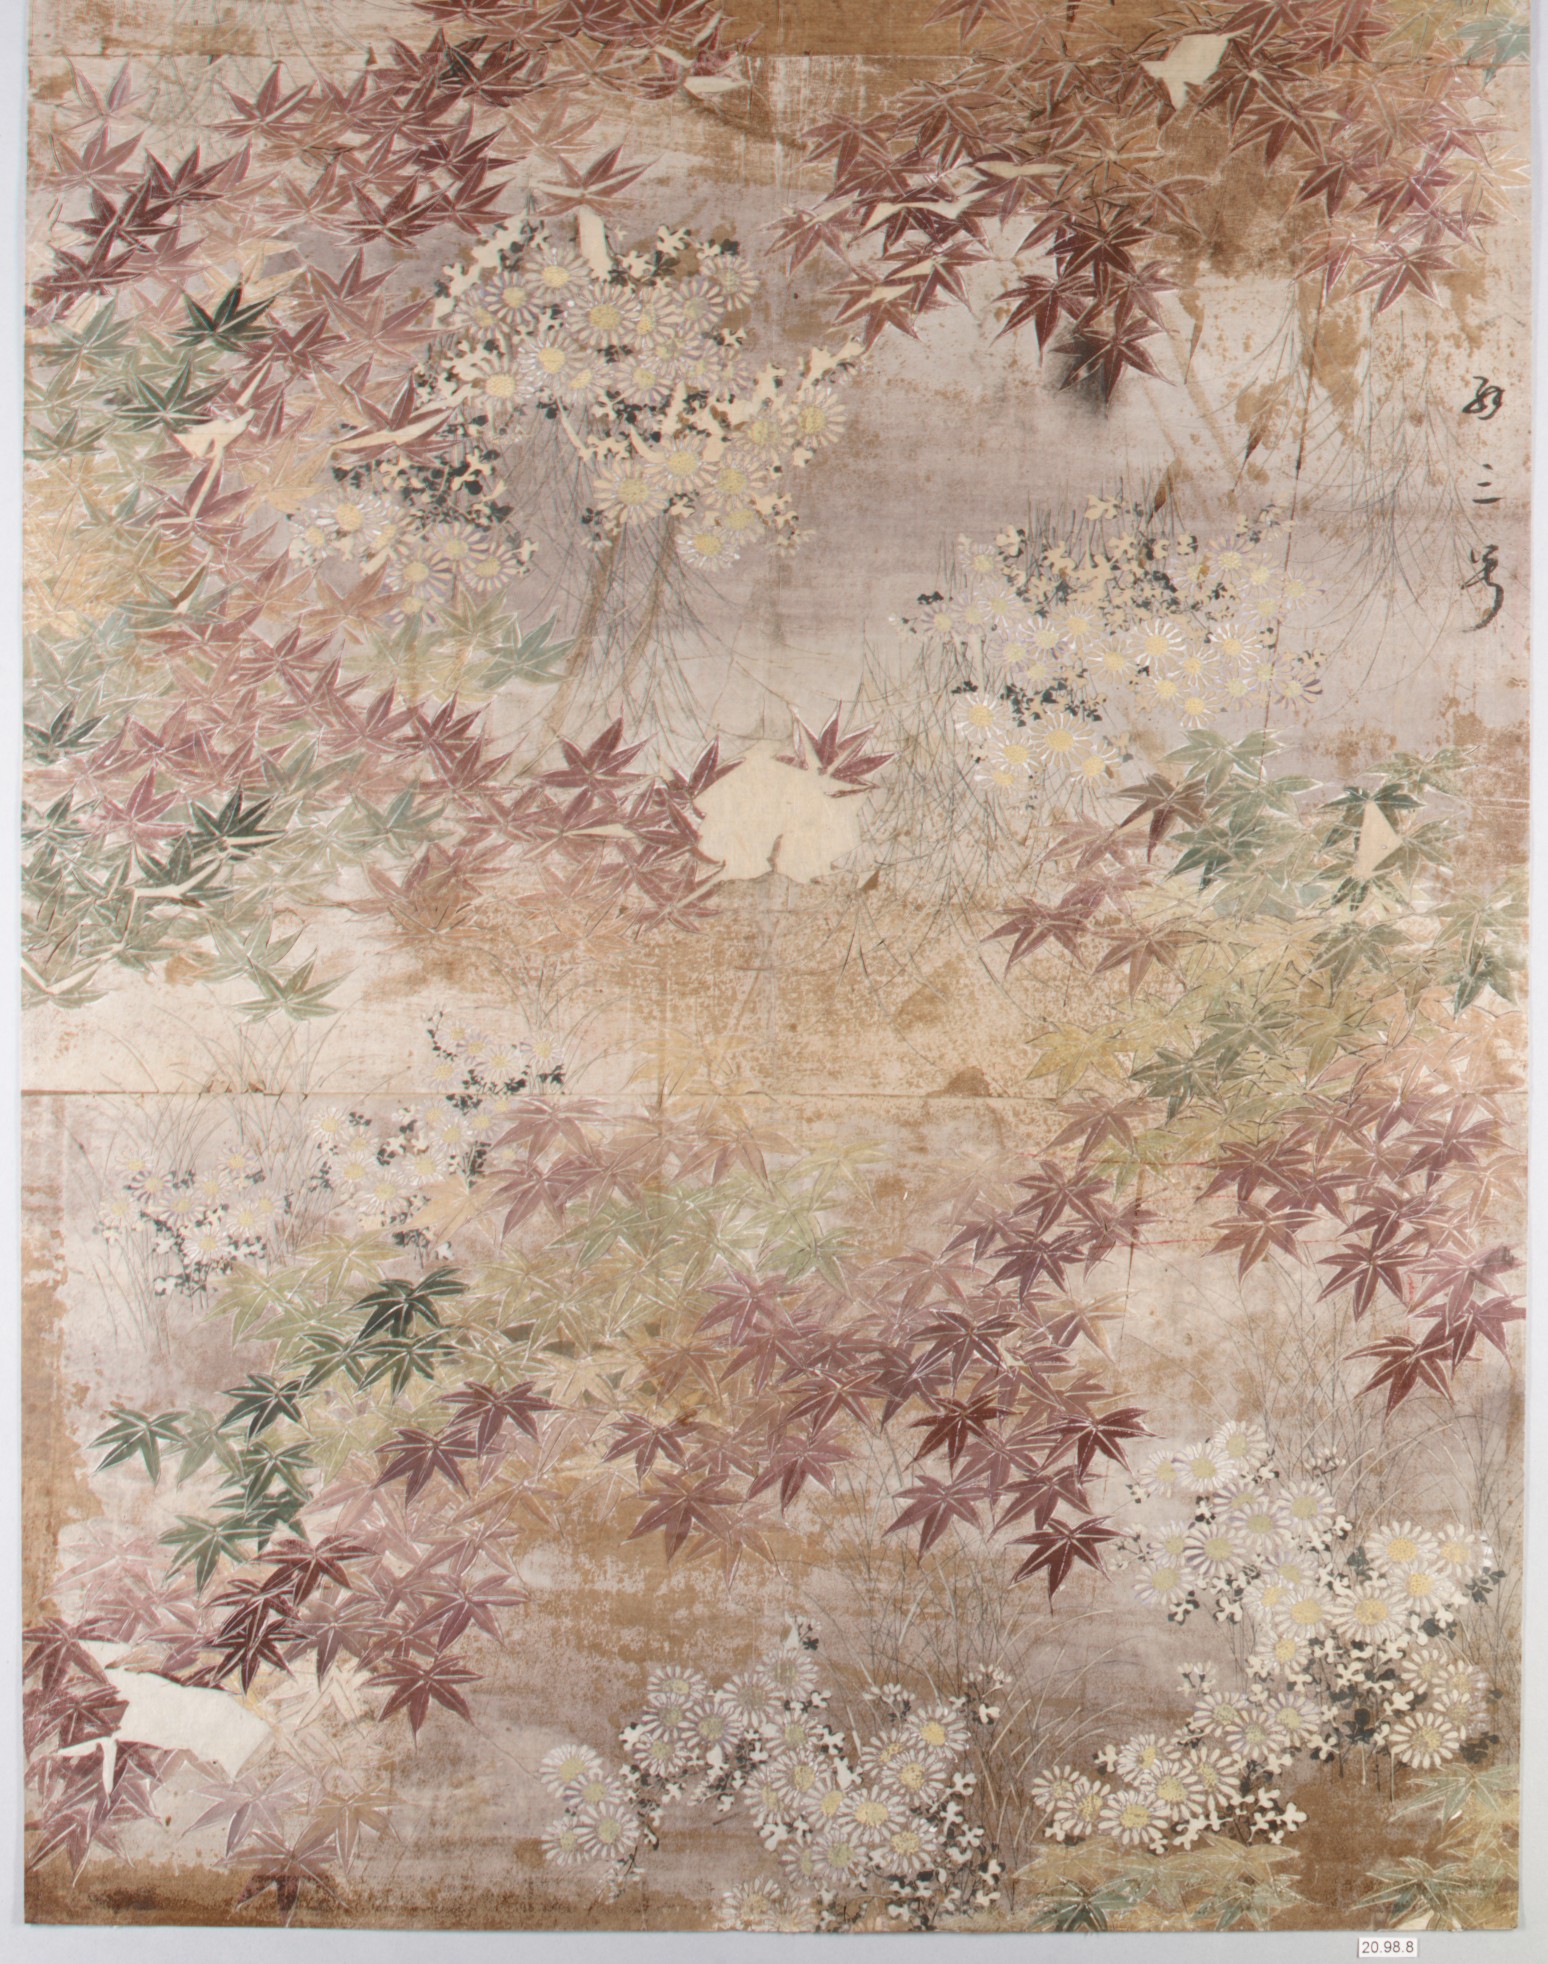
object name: textile design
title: Textile Design for Stencil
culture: japanese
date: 1601-1700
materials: paint, paper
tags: flowers,leaves